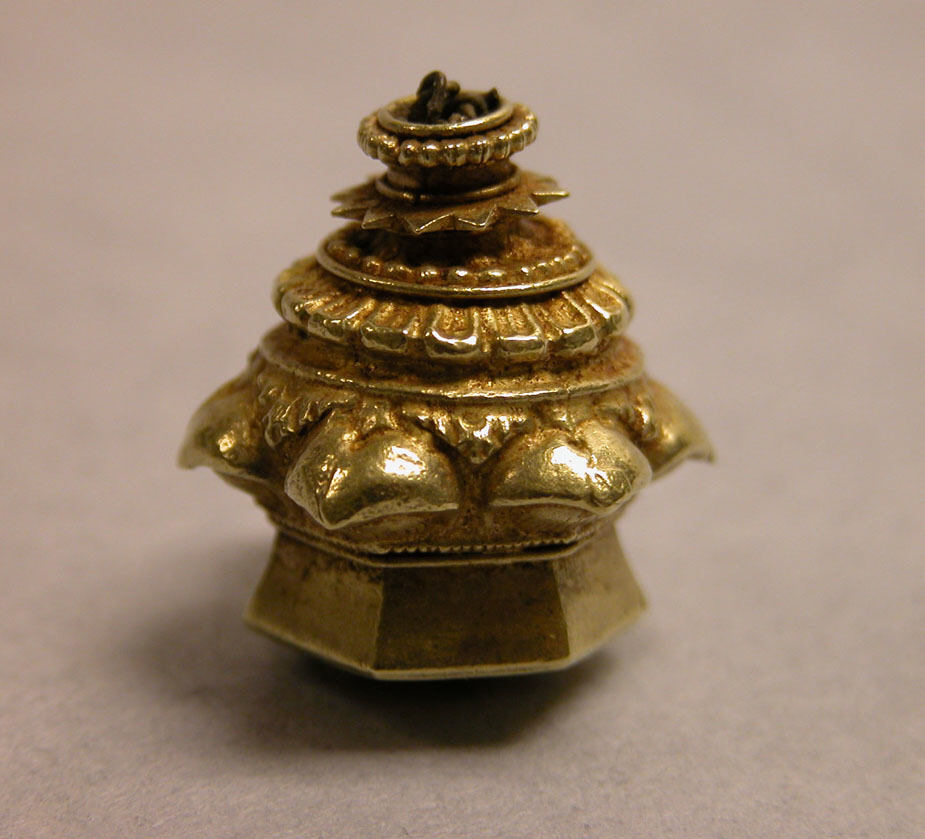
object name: ornament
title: Set of Two Ornaments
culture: indonesian, javanese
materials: gold